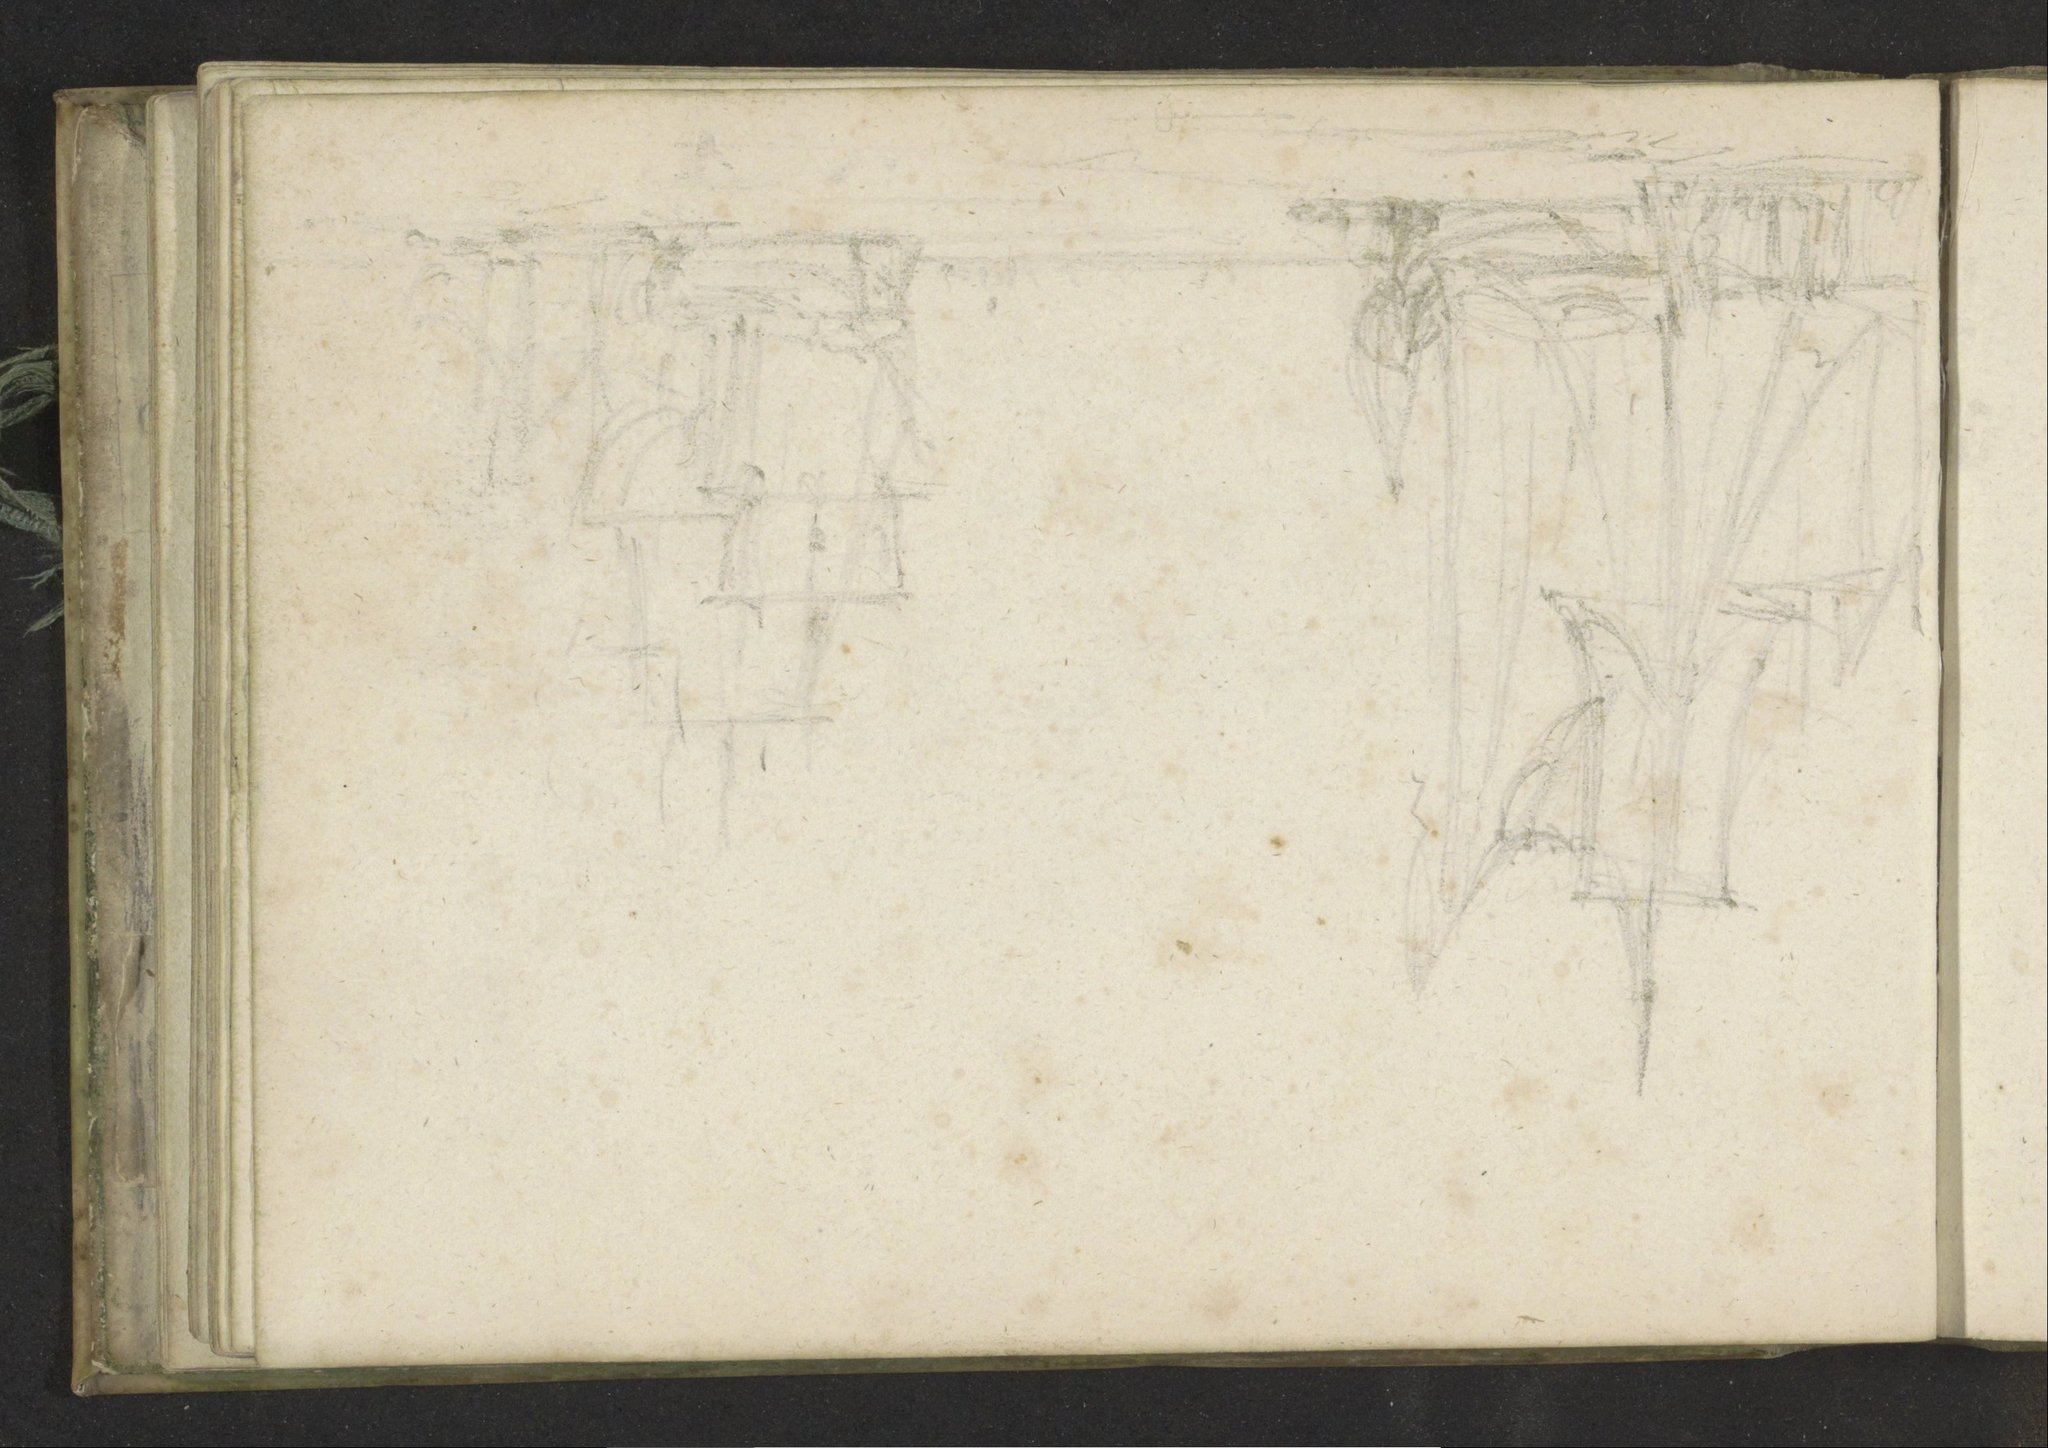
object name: sketchbook leaf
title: Twee zeilschepen voor een kust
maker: martinus schouman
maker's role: draughtsman, painter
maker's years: 1770-1848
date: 1780-1848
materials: paper, pencil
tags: sailing-ship, sailing-boat, coast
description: Blad 33 verso uit een schetsboek met 53 bladen.